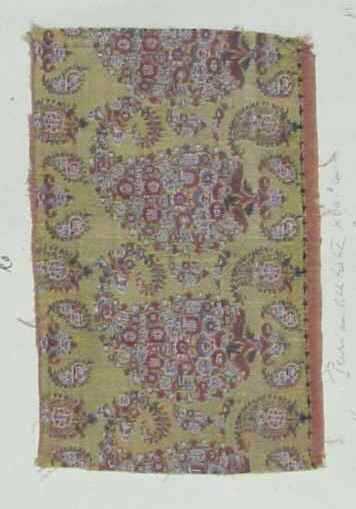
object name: textile fragment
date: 1601-1700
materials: metal thread, silk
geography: iran